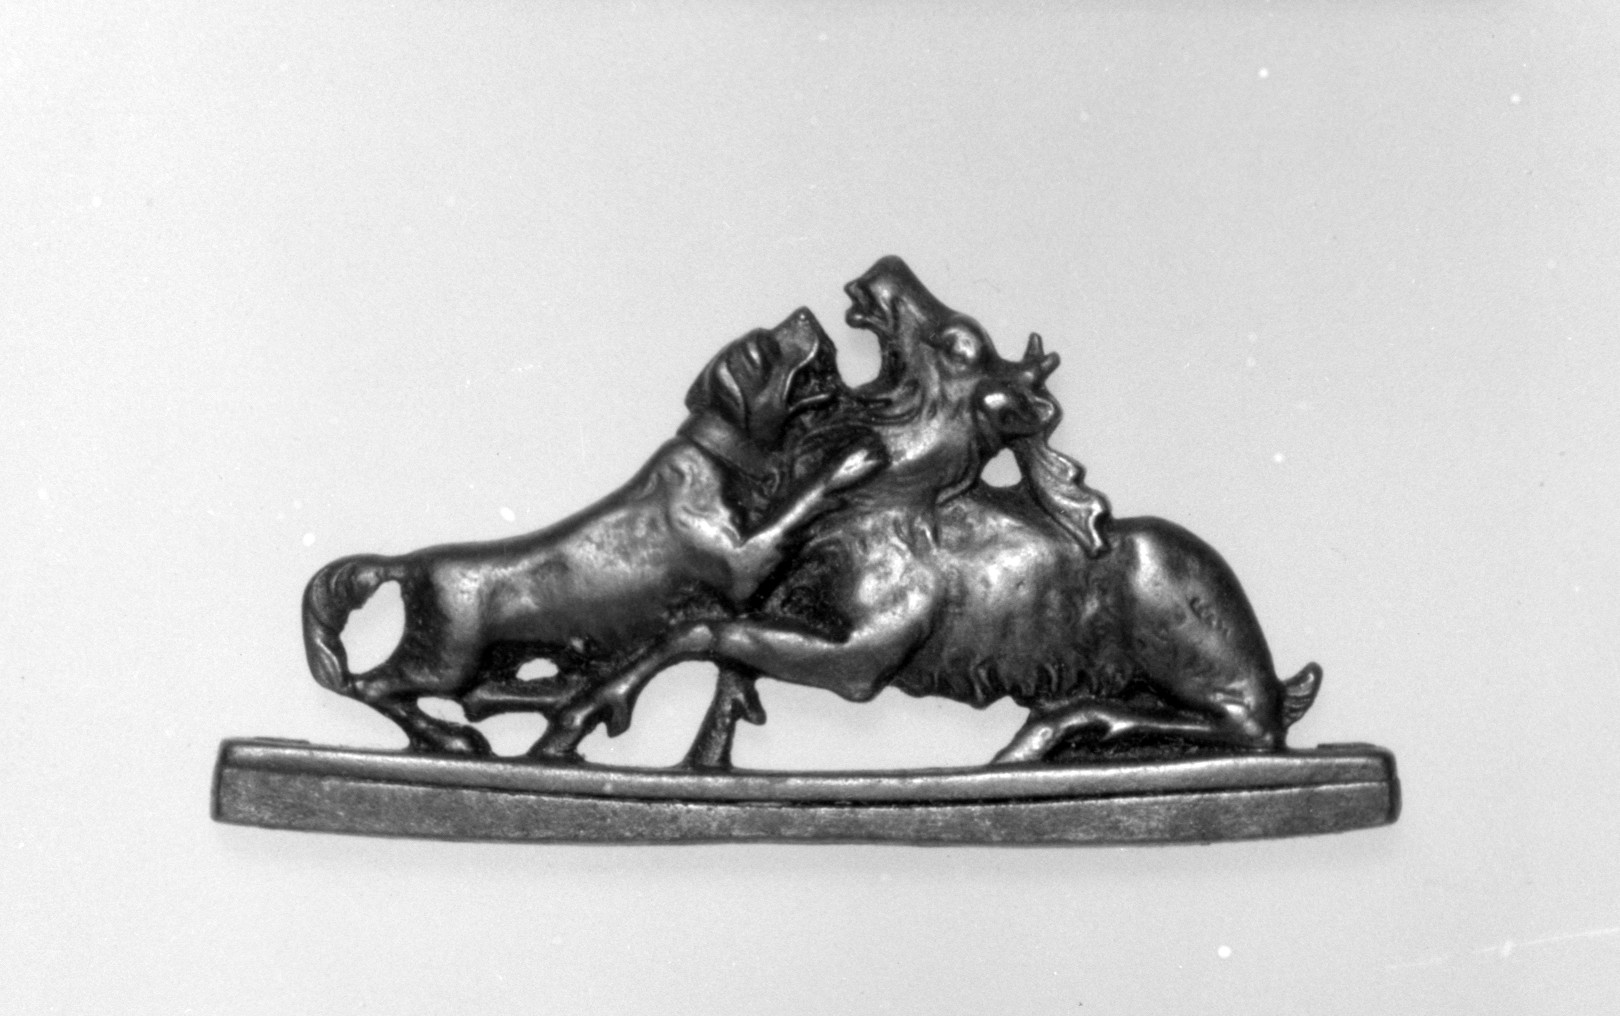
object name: strike plate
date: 1701-1800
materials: iron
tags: deer,dogs